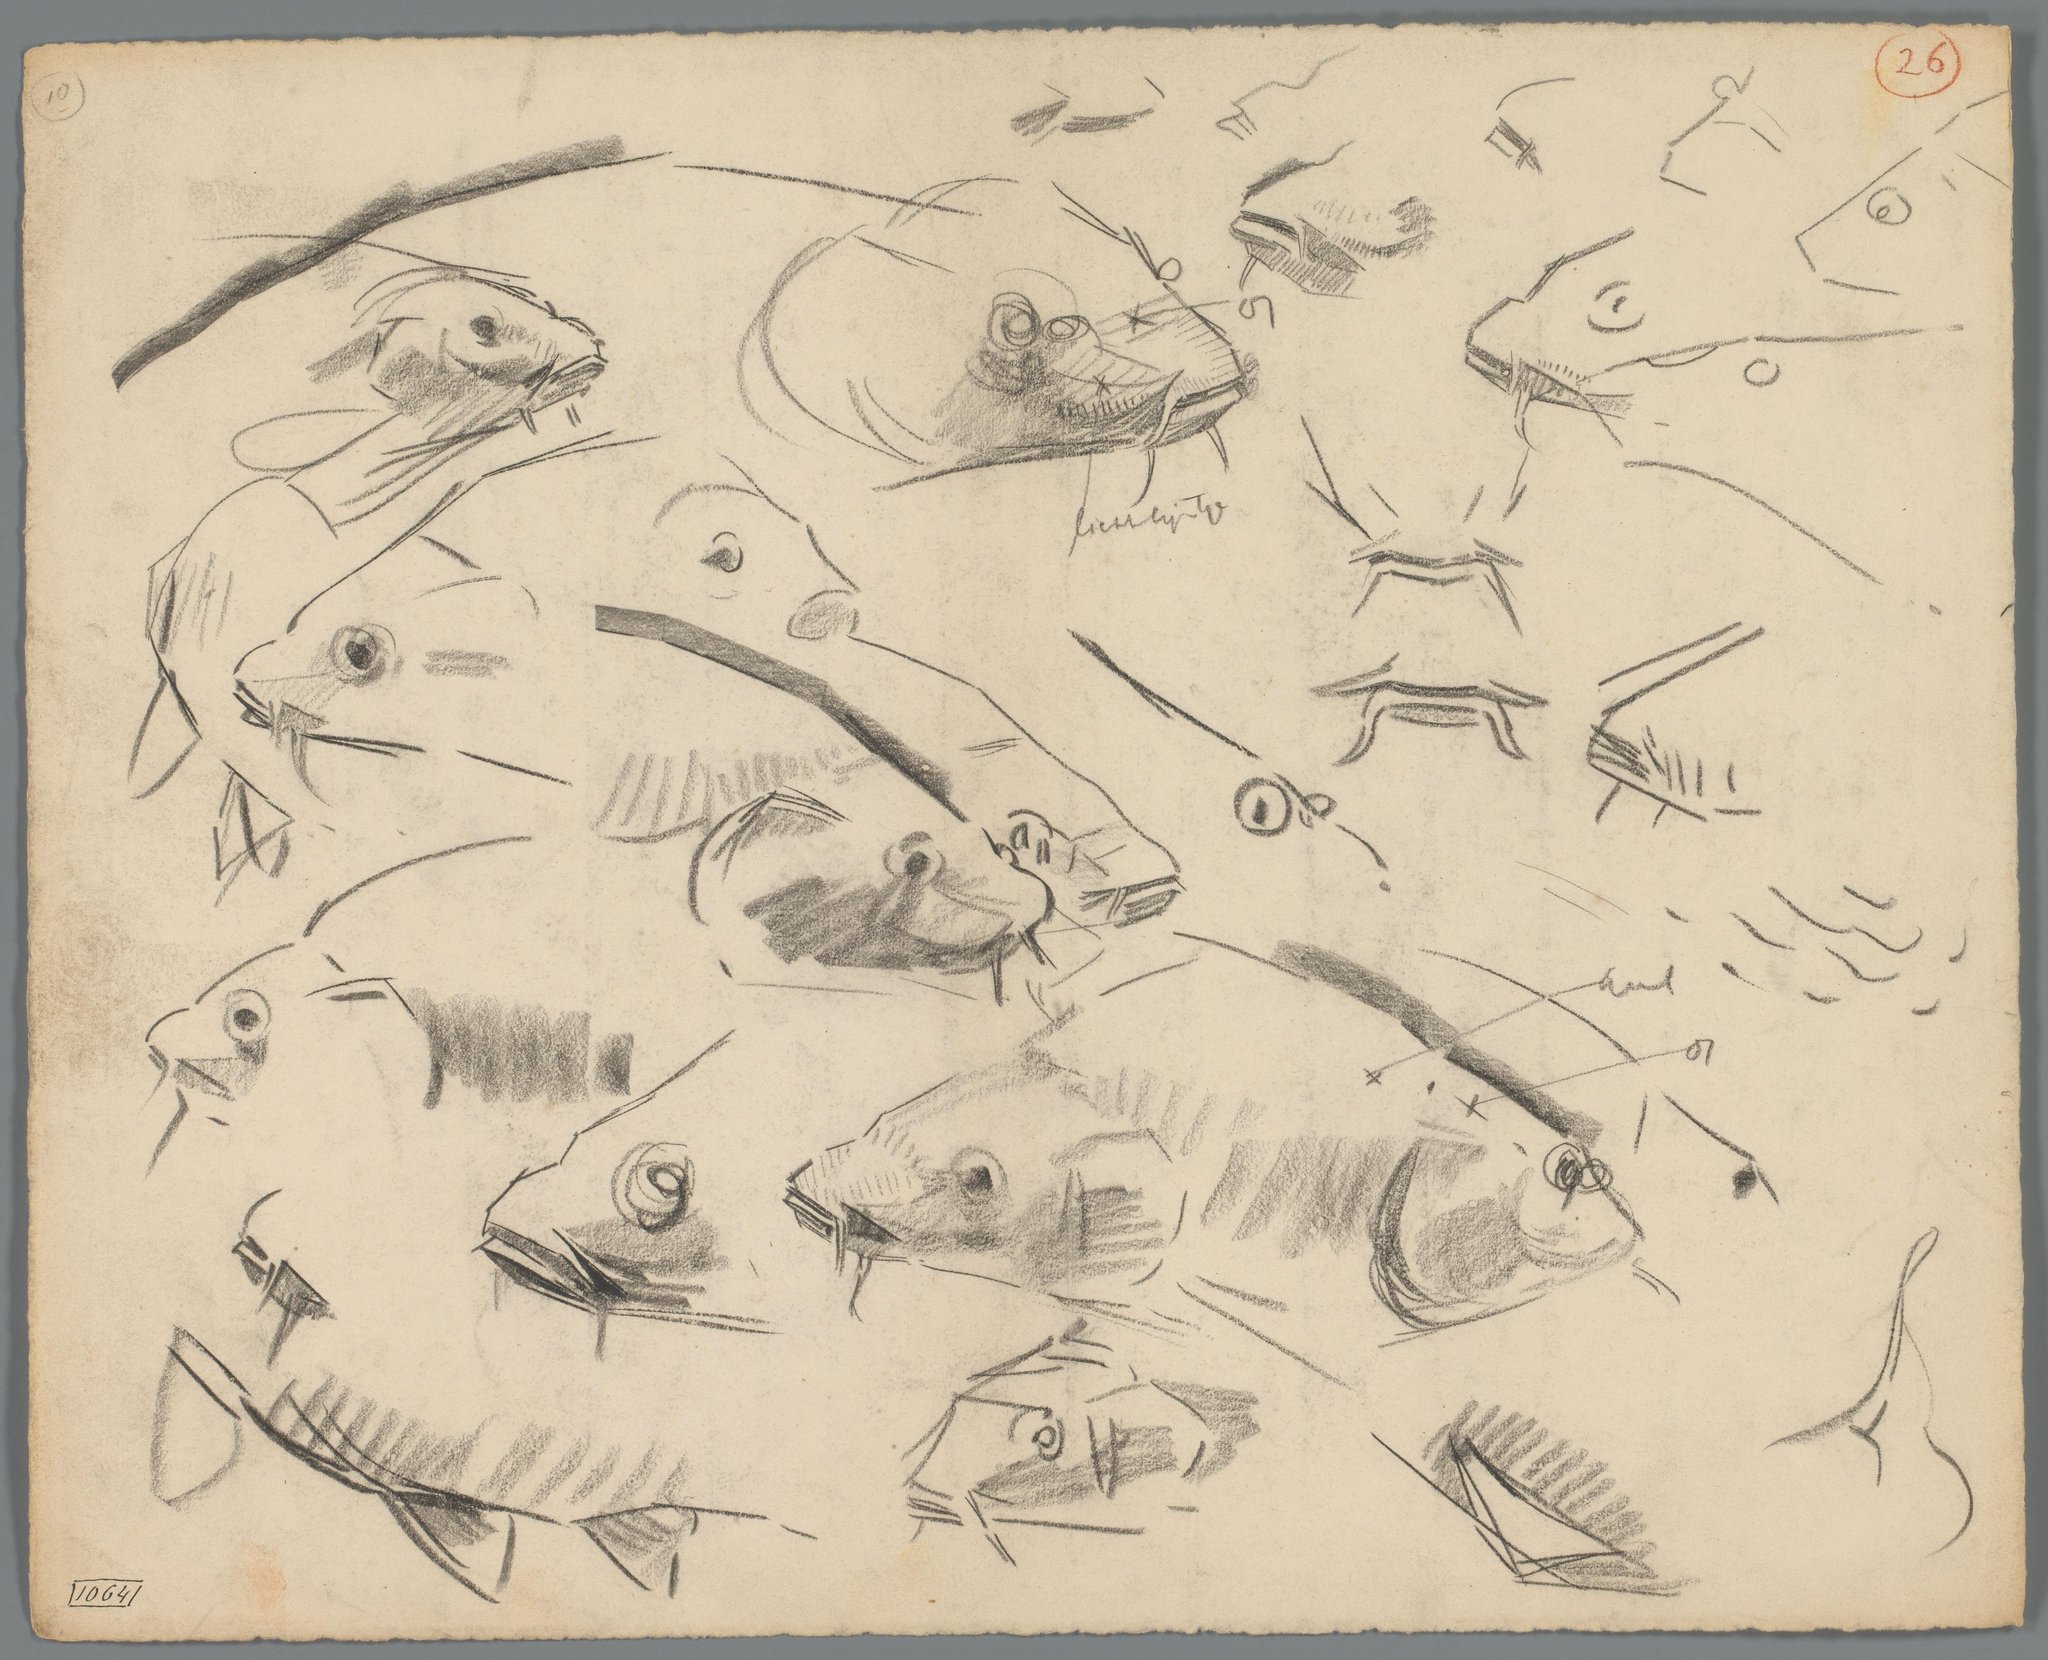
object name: drawing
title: Studies van de koppen van karpers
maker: gerrit willem dijsselhof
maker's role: designer, draughtsman, print maker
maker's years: 1866-1924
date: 1876-1924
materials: chalk, paper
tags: bony fishes: carp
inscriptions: number: ‘1064’